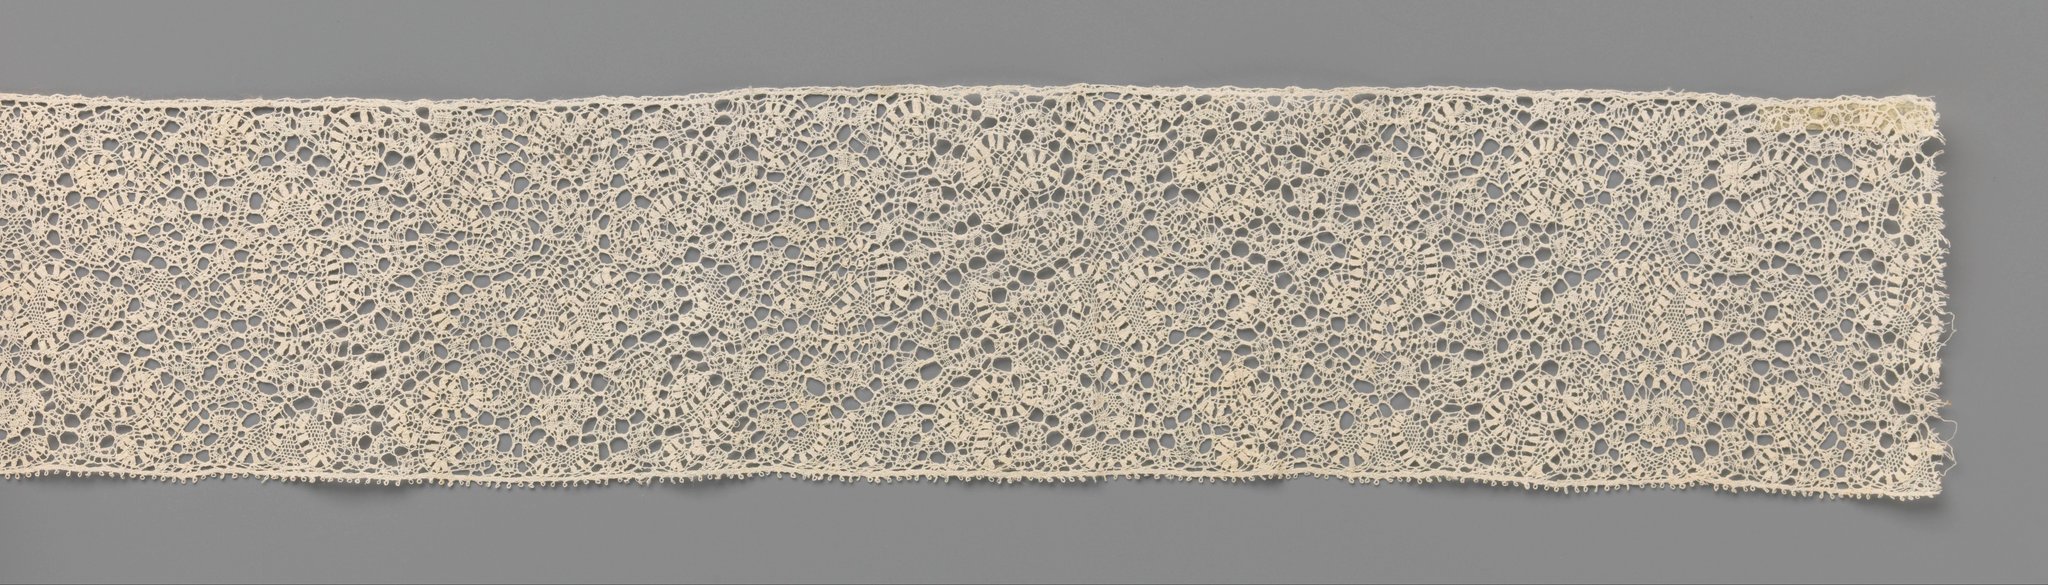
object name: strip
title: Strook kloskant met op mensen gelijkende figuurtjes gemaakt van smalle sierbandjes met rechthoekige vormslagen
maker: Anonymous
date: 1700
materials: linen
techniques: lace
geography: southern netherlands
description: Strook naturelkleurige kloskant, Binche-kant. Het zich herhalende patroon bestaat uit een wirwar van kleine motiefjes gemaakt met verschillende siergronden, waaronder vetergatslag-traliegrond en netslagvullingen. De omtrekken hiervan zijn gedeeltelijk benadrukt met smalle sierbandjes, gemaakt in vormslag. Op regelmatige afstand van elkaar vormen de sierbandjes op mensen gelijkende figuurtjes. De motieven zijn met elkaar verbonden door een onregelmatige siergrond, een sneeuwvlokkengrond. De boven- en onderzijde van de strook zijn recht afgewerkt, waarbij de onderzijde is voorzien van picots.